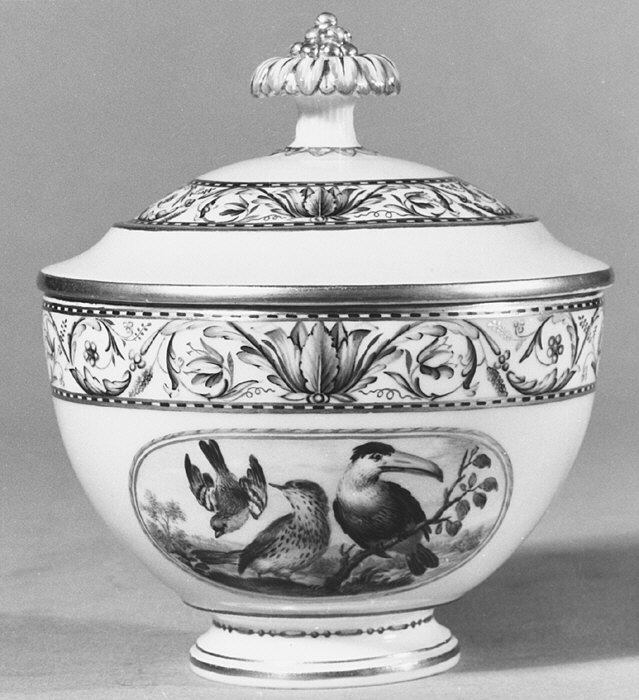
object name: sugar bowl with cover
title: Sugar bowl with cover (part of a service)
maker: meissen manufactory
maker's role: manufactory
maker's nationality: german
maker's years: 1710-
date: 1780-1785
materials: hard paste porcelain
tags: birds,flowers